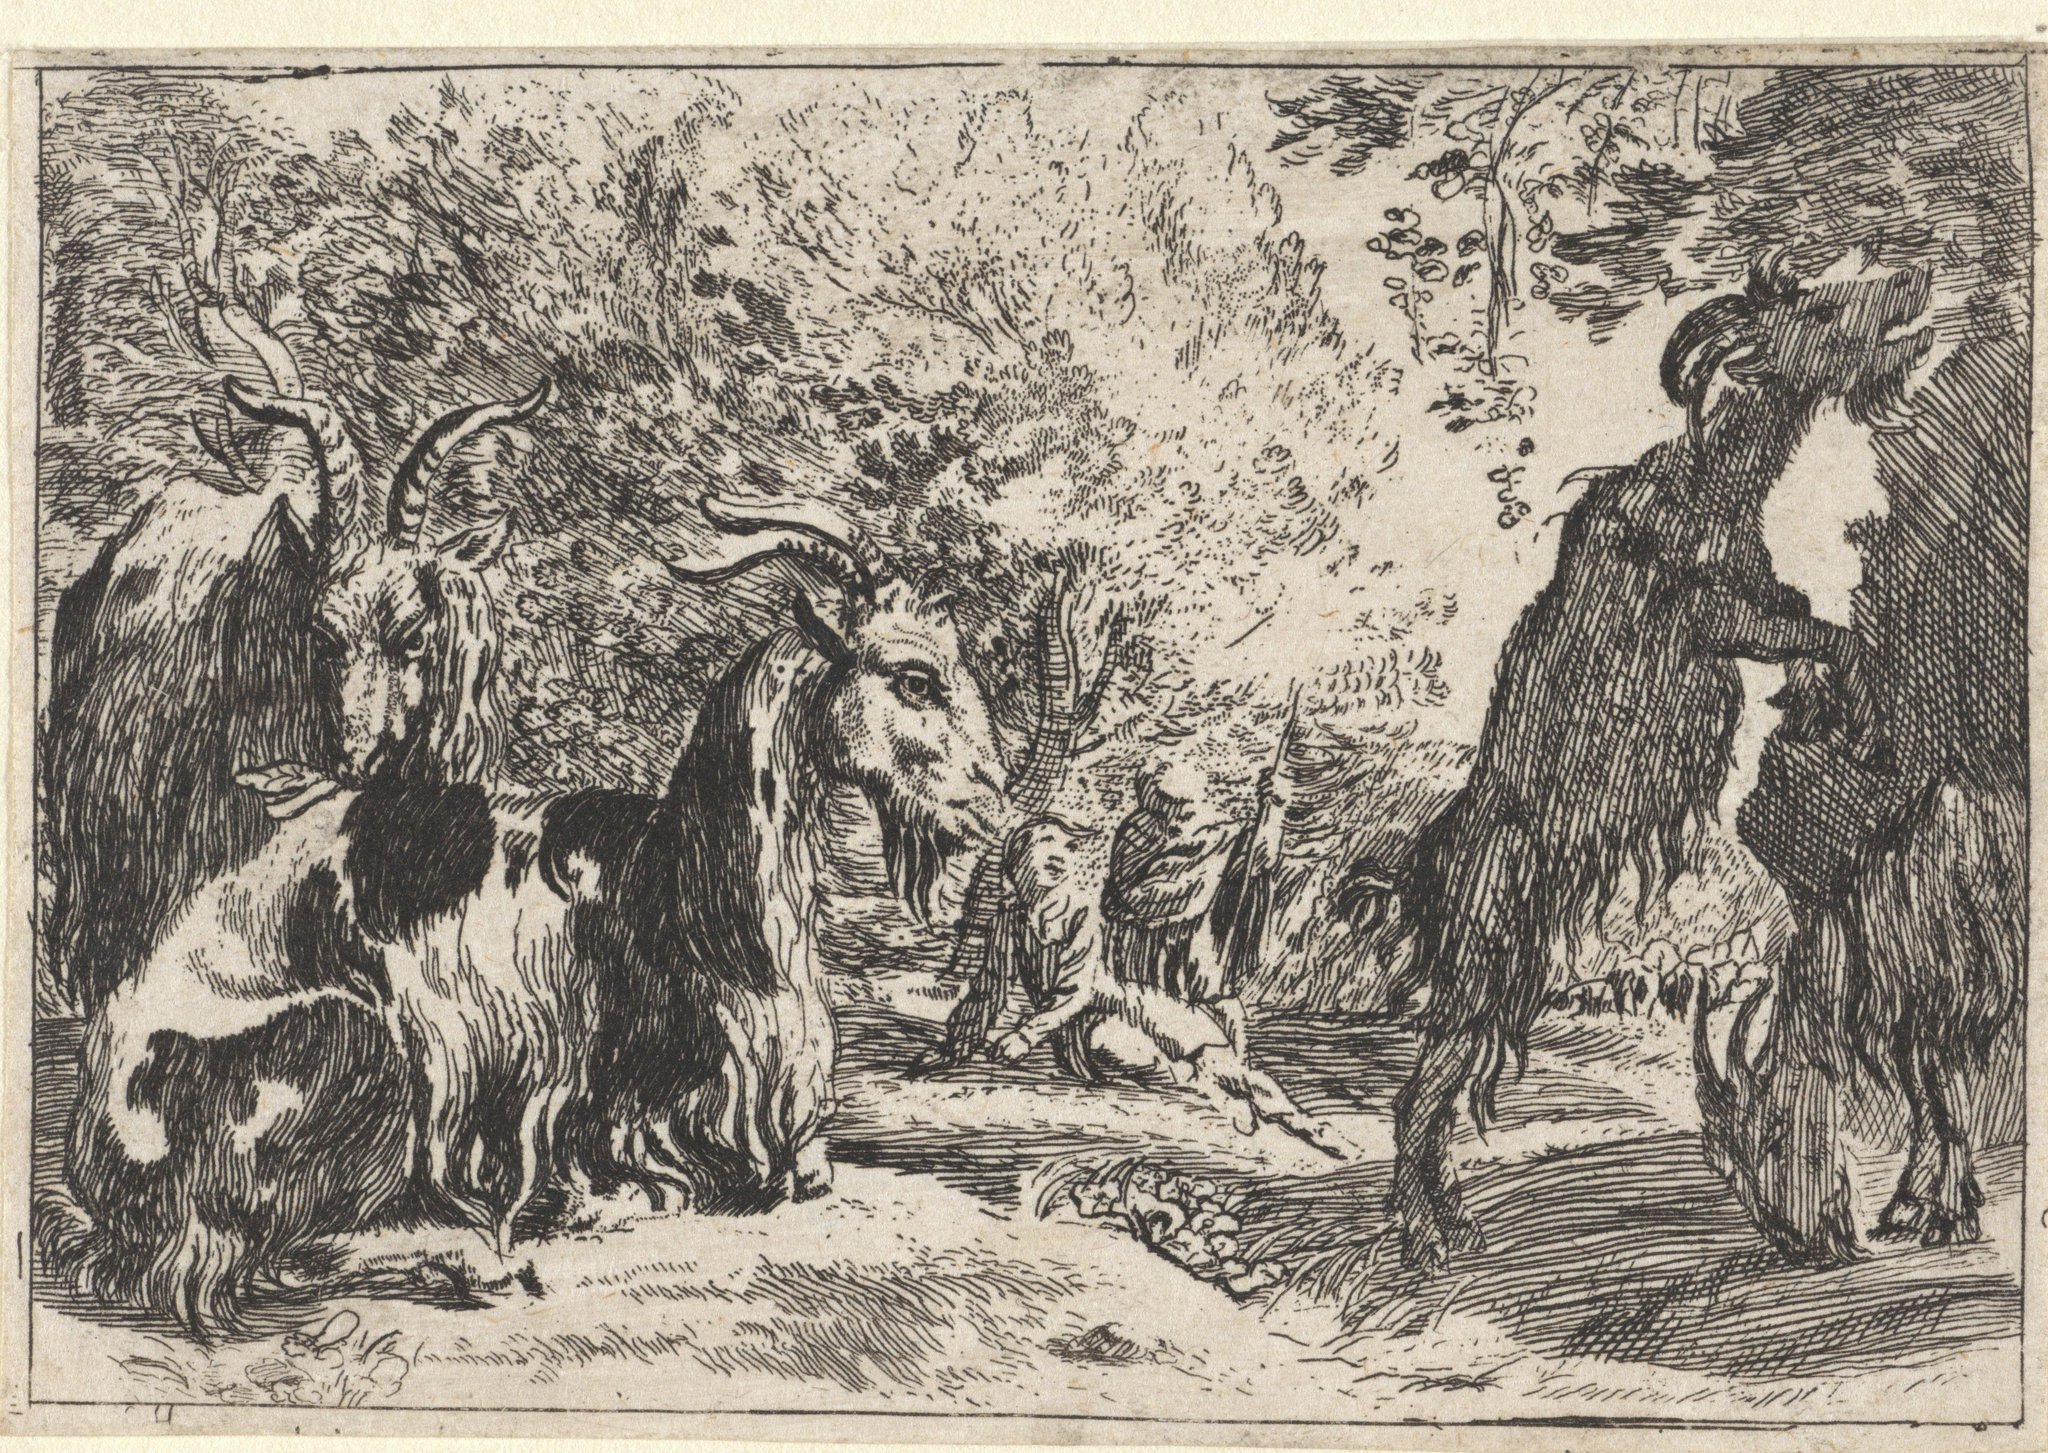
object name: print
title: Landschappen met dieren (serie B)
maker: Anonymous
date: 1636-1705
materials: paper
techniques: etching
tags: landscapes, herding, herdsman, herdswoman, shepherd, shepherdess, cowherd, etc., goat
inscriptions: collector's mark: Lugt 240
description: Links eet een geit van een boom en rechts zijn nog twee geiten te zien. Achter hen staat de herder bij de herderin.